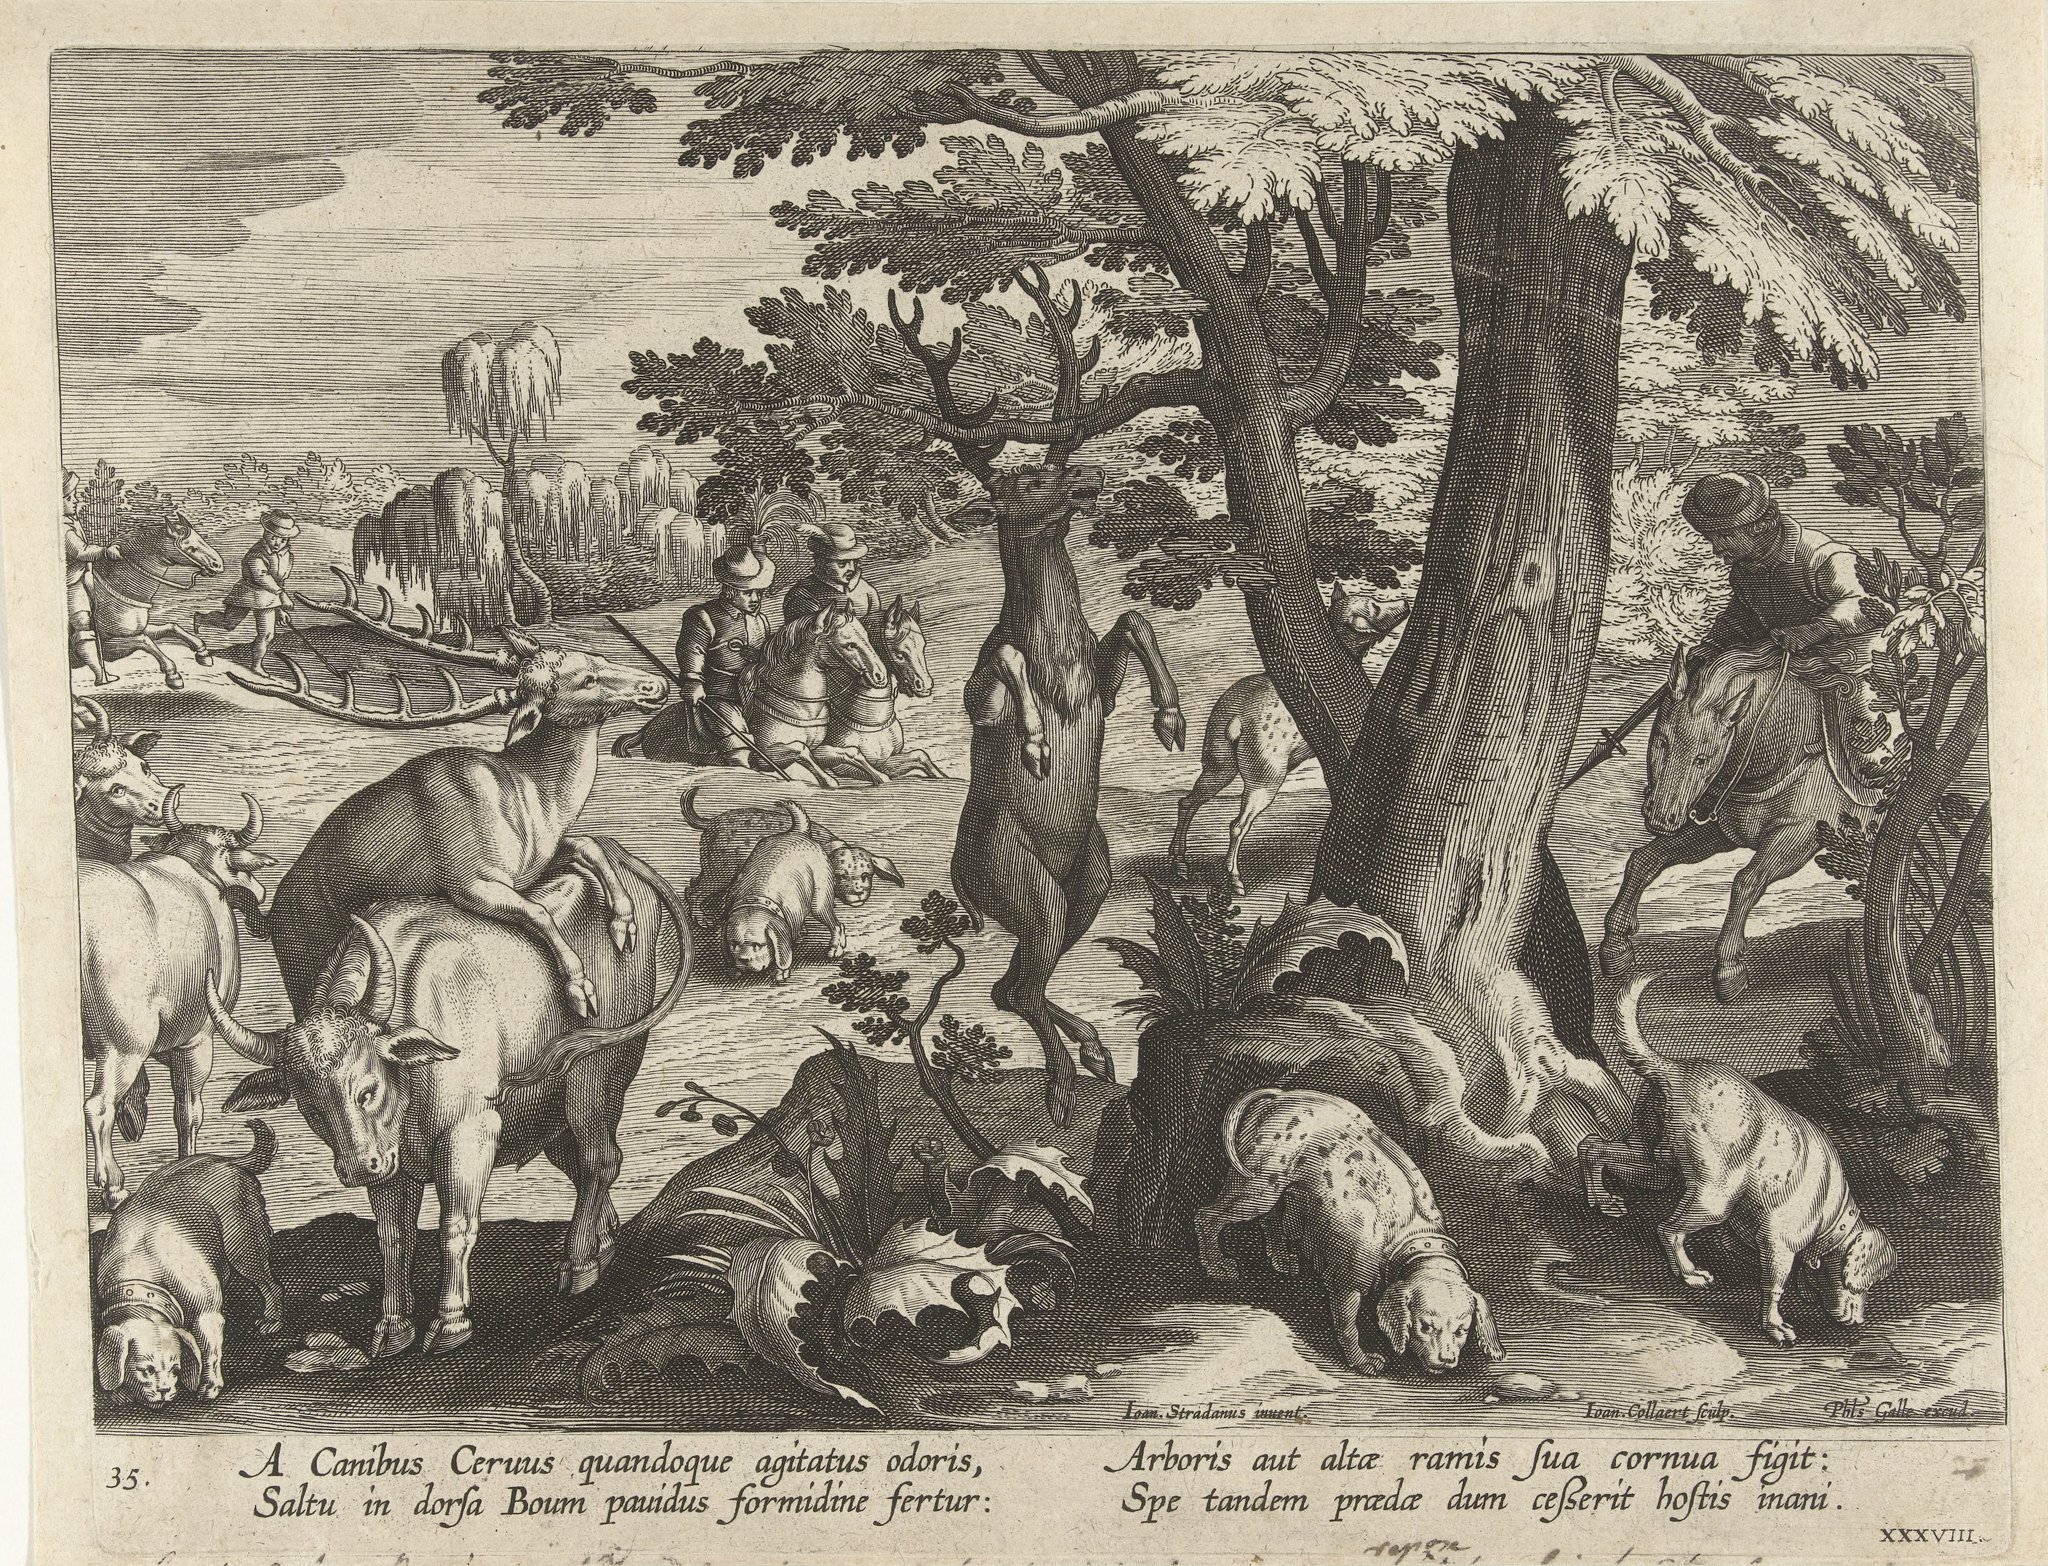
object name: print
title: Hertenjacht met honden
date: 1596-1628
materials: paper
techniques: engraving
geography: florence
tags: stag-hunting, hoofed animals: stag - ff - fabulous animals (sometimes wrongly called 'grotesques'); 'mostri' (ripa) (+ observation of animals)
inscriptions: collector's mark: Lugt 2228, caption: ‘repose’, collector's mark: Lugt 2760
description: Een hertenjacht met honden. De herten proberen de honden te ontvluchten door op een os te springen of door met hun gewei in een boom te hangen. De prent heeft een Latijns onderschrift en is deel van een serie over jachttaferelen.